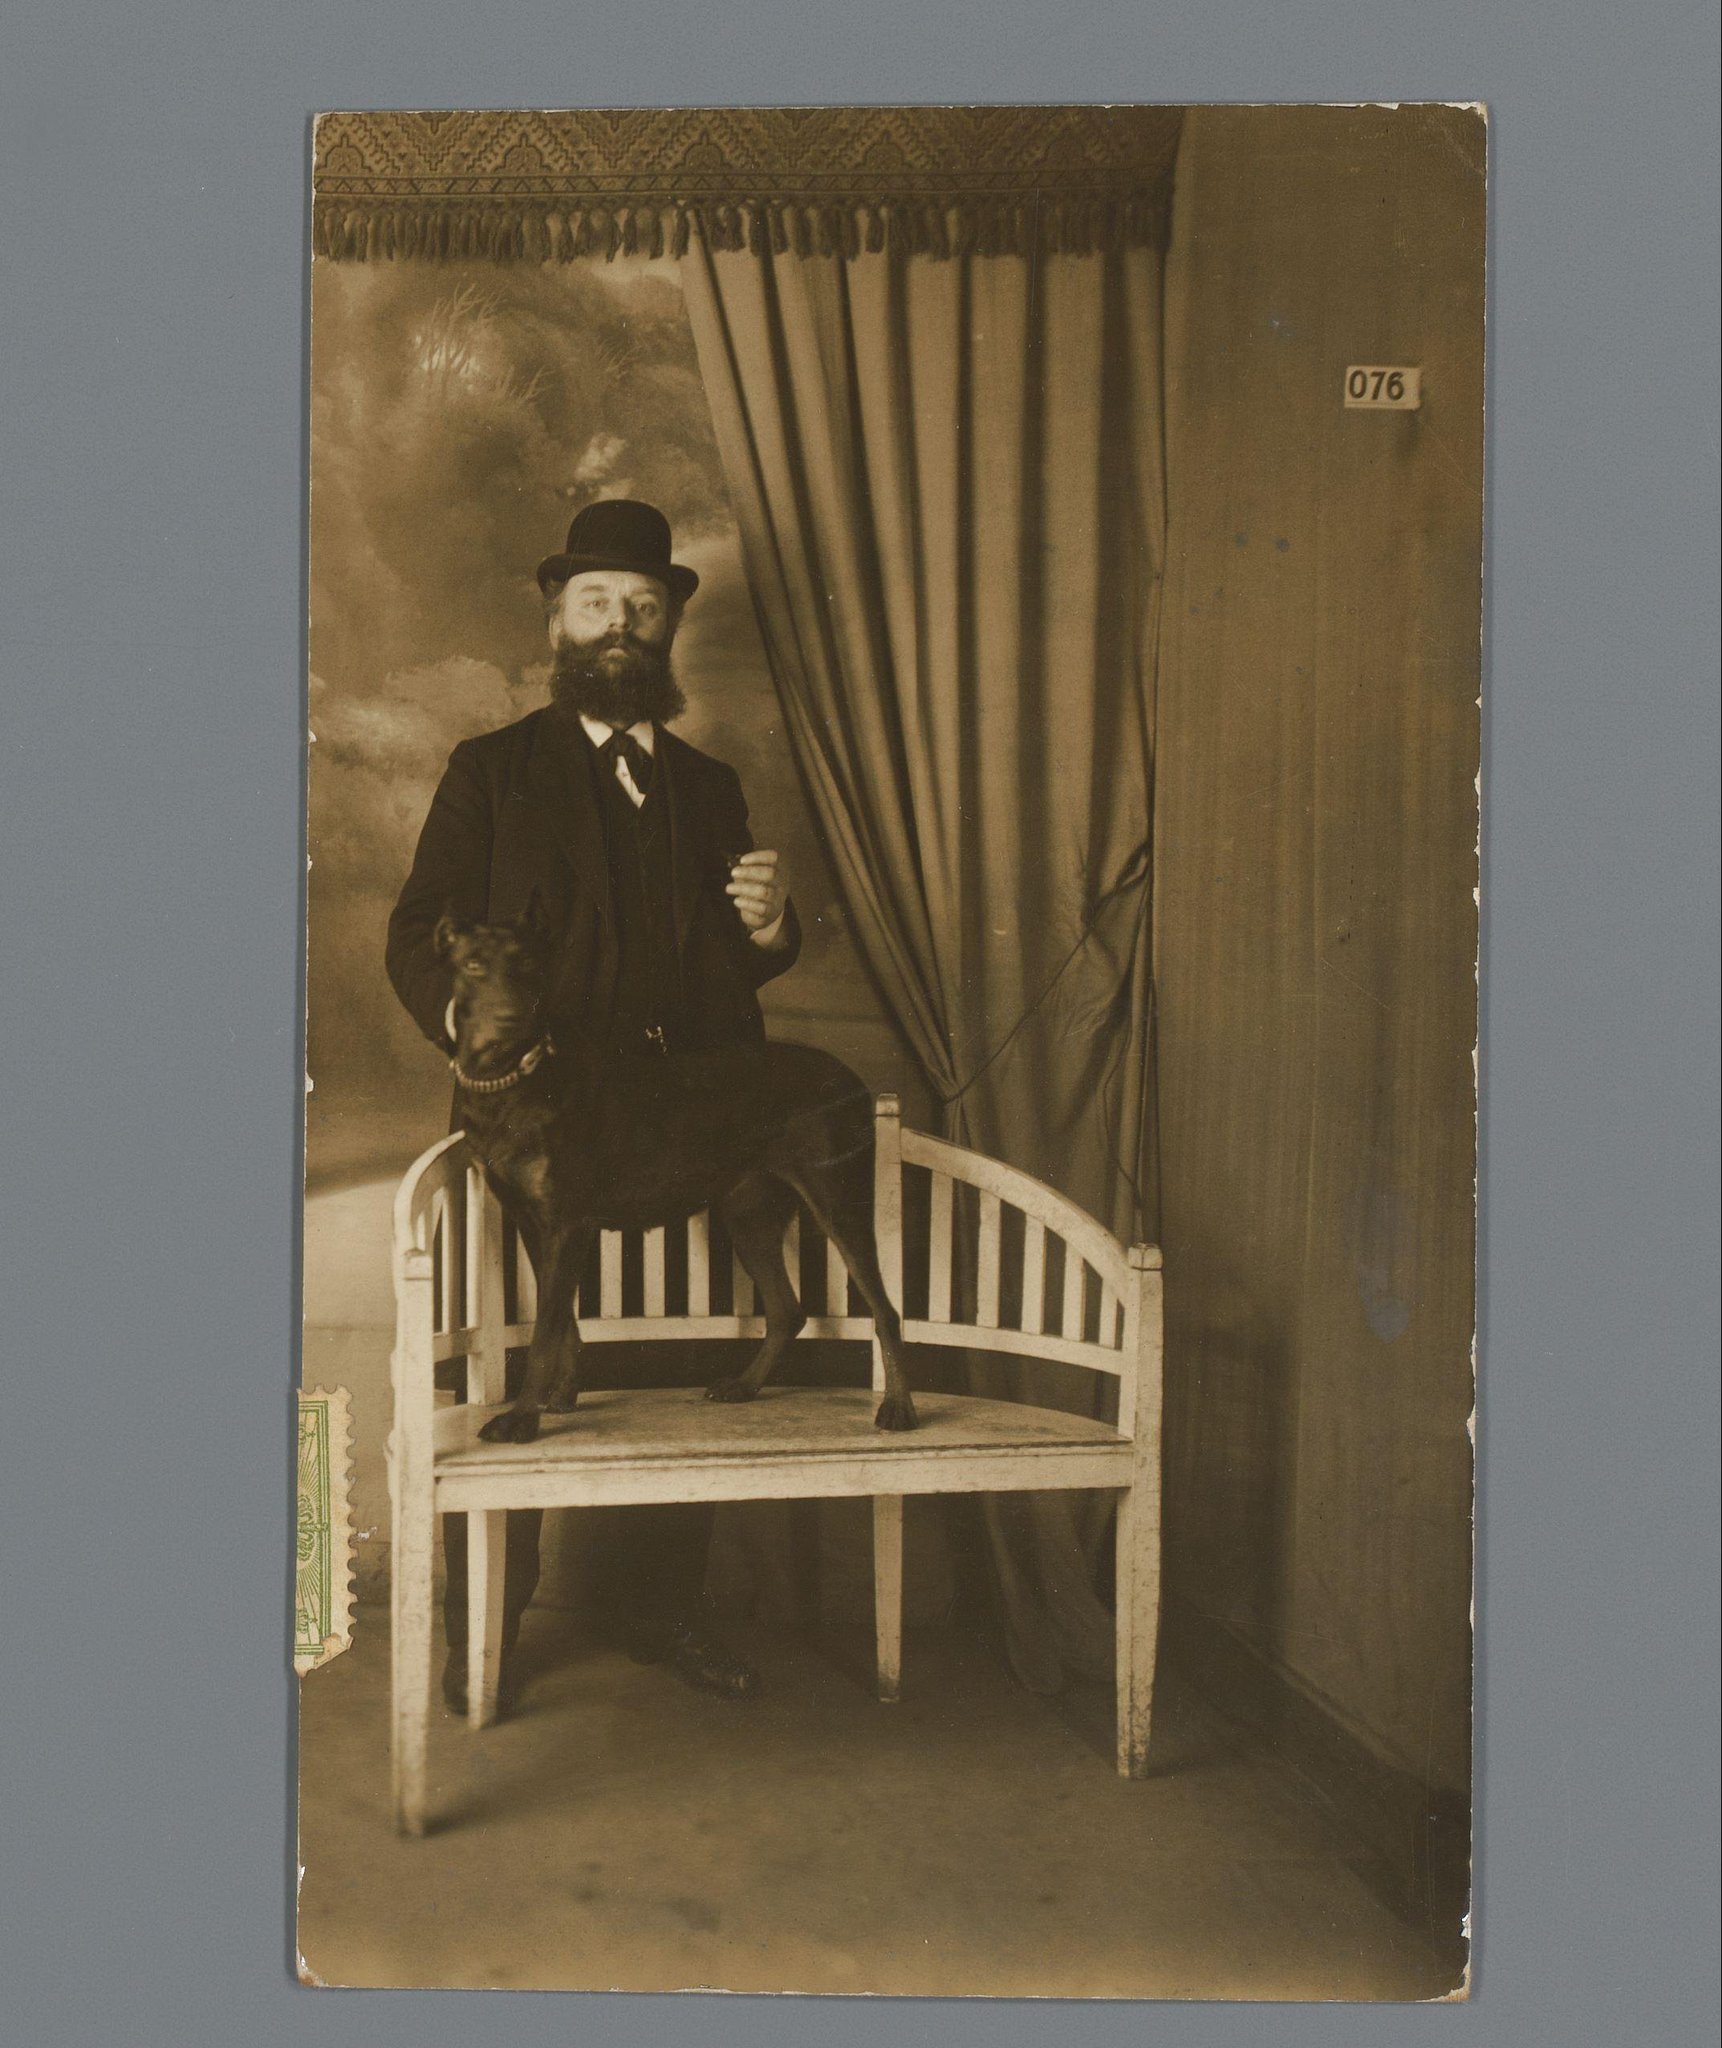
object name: ansichtkaart, prentbriefkaart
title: Portret van een onbekende man met hond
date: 1917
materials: paper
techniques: gelatin silver print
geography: amsterdam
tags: adult man, anonymous historical person portrayed, dog, amsterdam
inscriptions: inscription: ‘N.A. Fen (...)/ 13 Willem Lodewijker/ Leeuwarden’, inscription: ‘AMERICAN AUTOMATIC FOTOGRAFIE/ Kalverstraat 155.’, inscription: ‘AMSTERDAM/ 1-2/ 3 . I/ 1917’